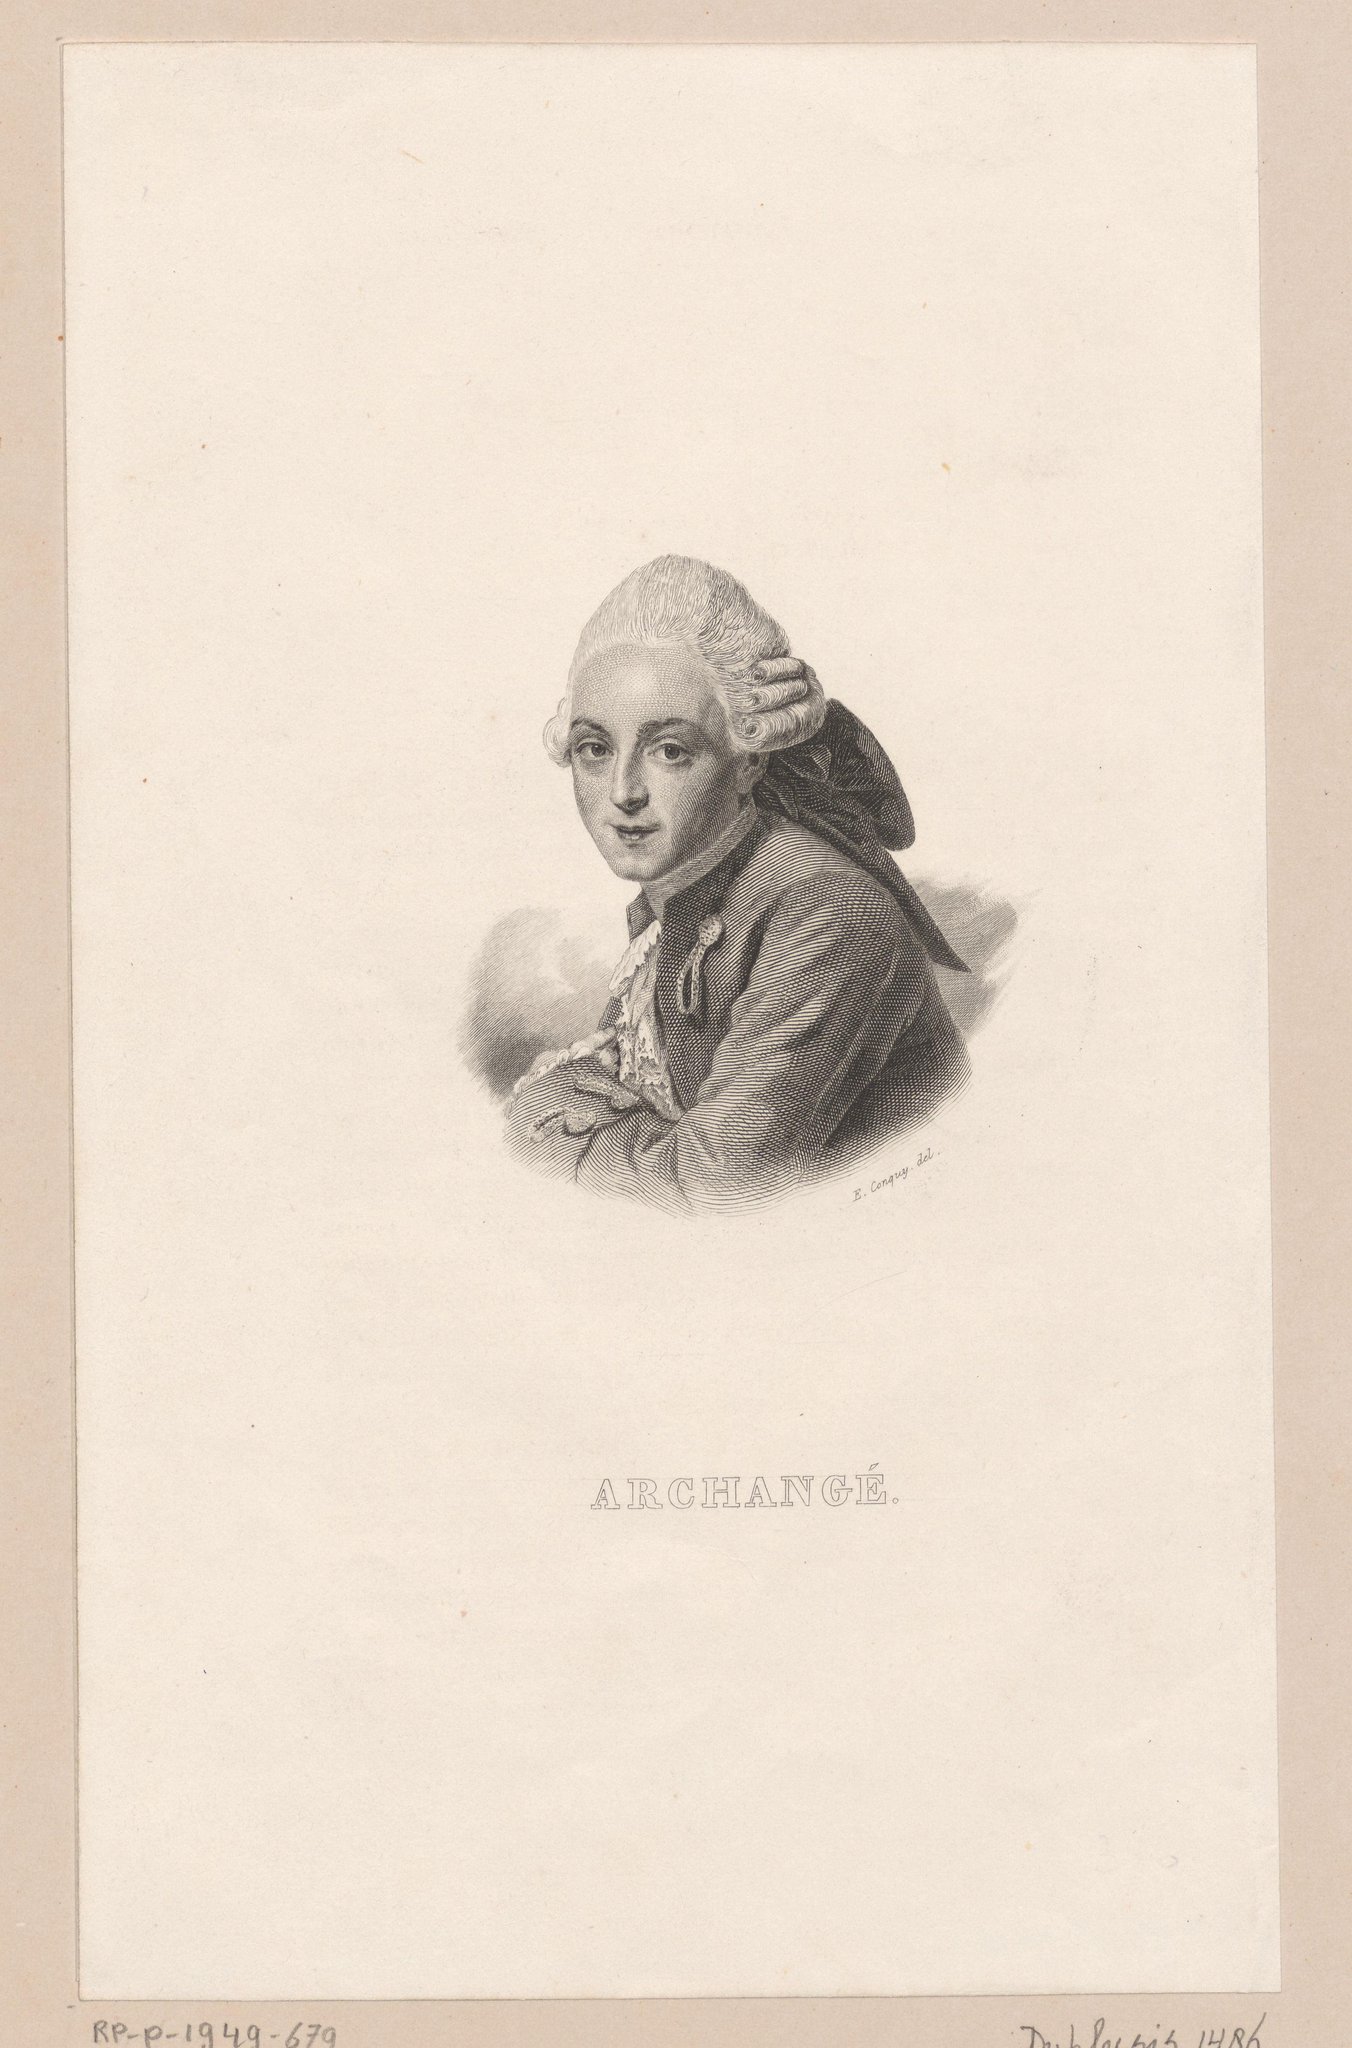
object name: print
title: Portret van Jean-Louis Archangé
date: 1841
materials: paper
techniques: engraving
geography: paris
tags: historical persons, portrait, self-portrait of architect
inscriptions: collector's mark: Lugt 2228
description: Prent uit: Mancy, Jarry de. Portraits et histoire des hommes utiles bienfaiteurs et bienfaitrices de tous pays et de toutes conditions. Parijs: Paul Renouard, 1841, dl. 4, p. 449.